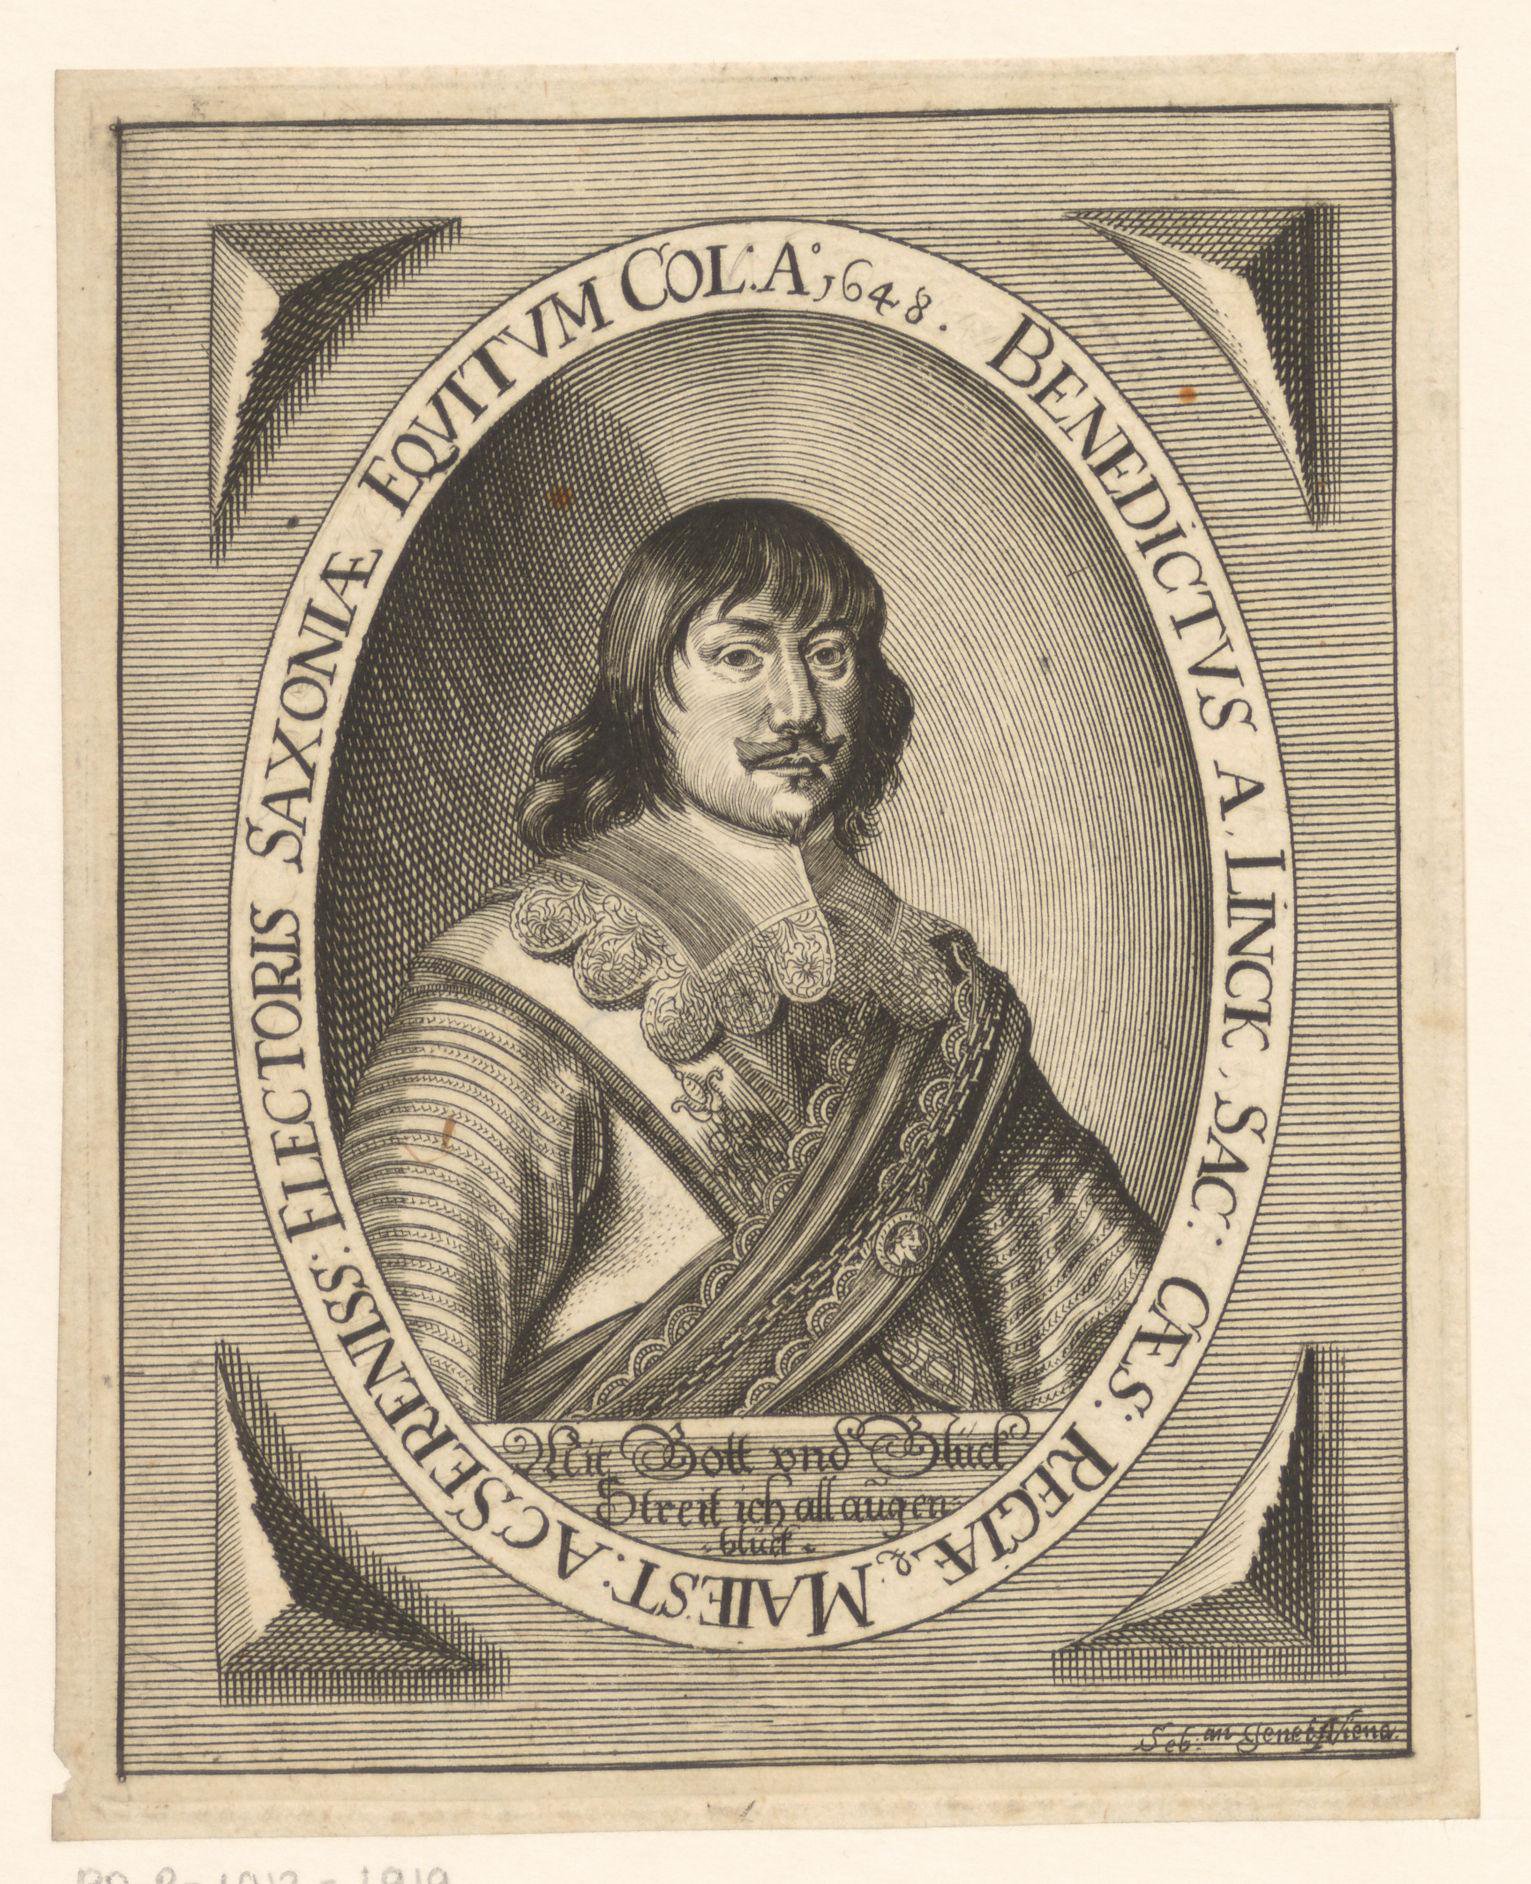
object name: print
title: Portret van Benedict von Linck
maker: sebastian jenet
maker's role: draughtsman, print maker, publisher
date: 1648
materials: paper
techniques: engraving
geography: vienna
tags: historical persons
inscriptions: collector's mark: Lugt 2228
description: Deze prent maakt deel uit van een serie van achttien portretten voor: Widemann, Elias. Comitium Gloriae Centum Qua Sanguine Qua Virtute Illustrium Heroum Iconibus Instructum Et Excelmo. Ac Illustrissimo Heroi D.D. Joanni Christophoro Com: a Puchaim (...) Dicatum. Wenen: Matthaeus Cosmerovius, 1650.